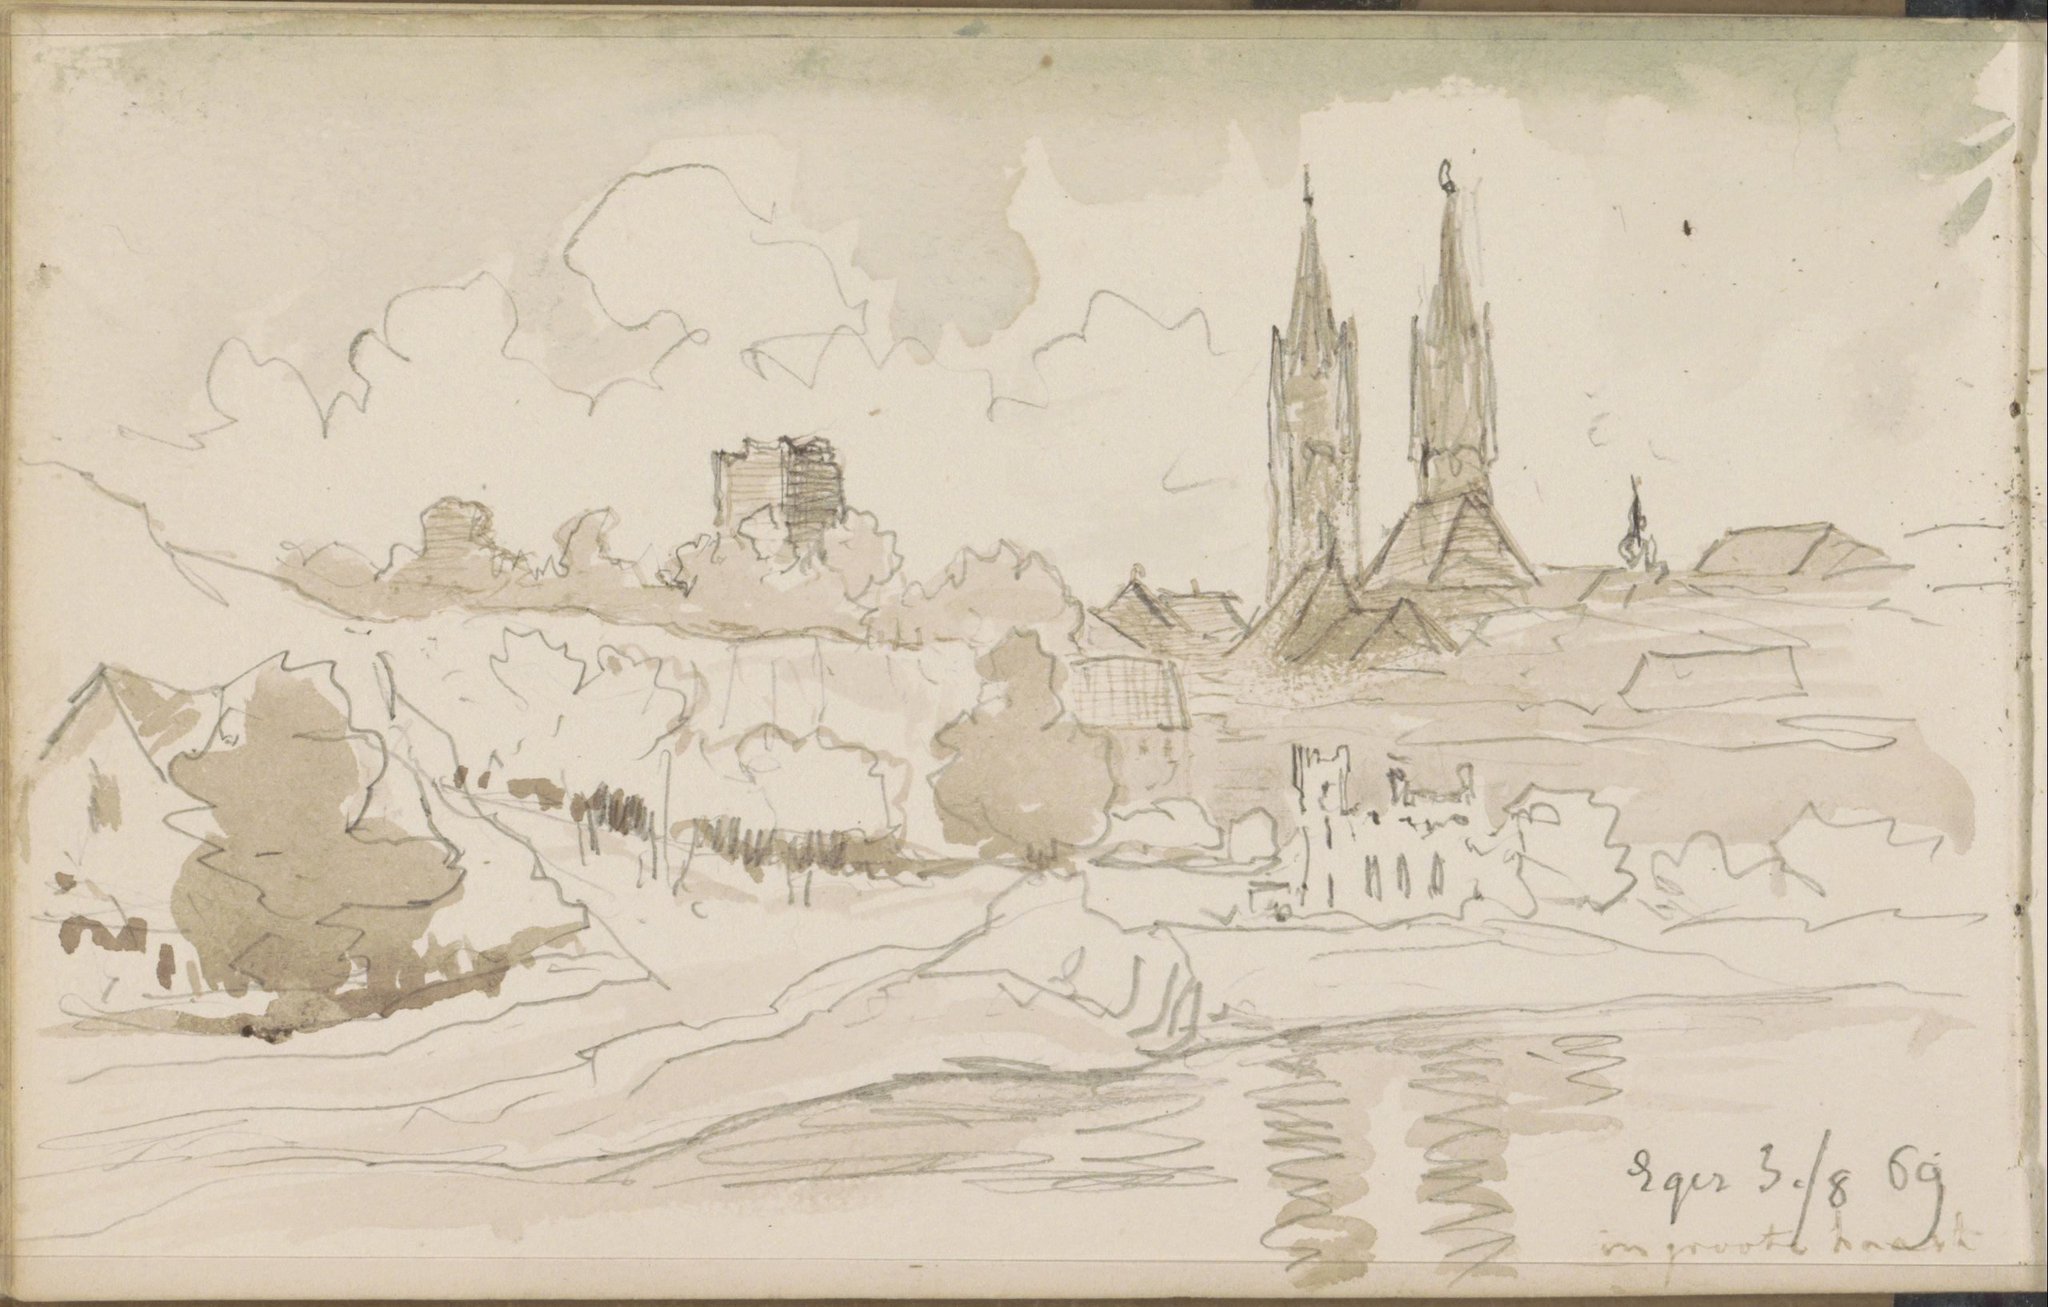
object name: sketchbook leaf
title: Gezicht op Eger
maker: johannes tavenraat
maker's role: draughtsman, painter, print maker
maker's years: 1809-1881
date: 1808-1869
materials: ink, paper, pencil, watercolor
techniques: brush, pen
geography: eger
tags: city-view, and landscape with man-made constructions, landscapes with waters, waterscapes, seascapes (in the temperate zone), church (exterior)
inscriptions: date and inscription: ‘Eger 3./9 69/ in groote haa[...]’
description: Blad 21 verso uit een schetsboek met 48 bladen.